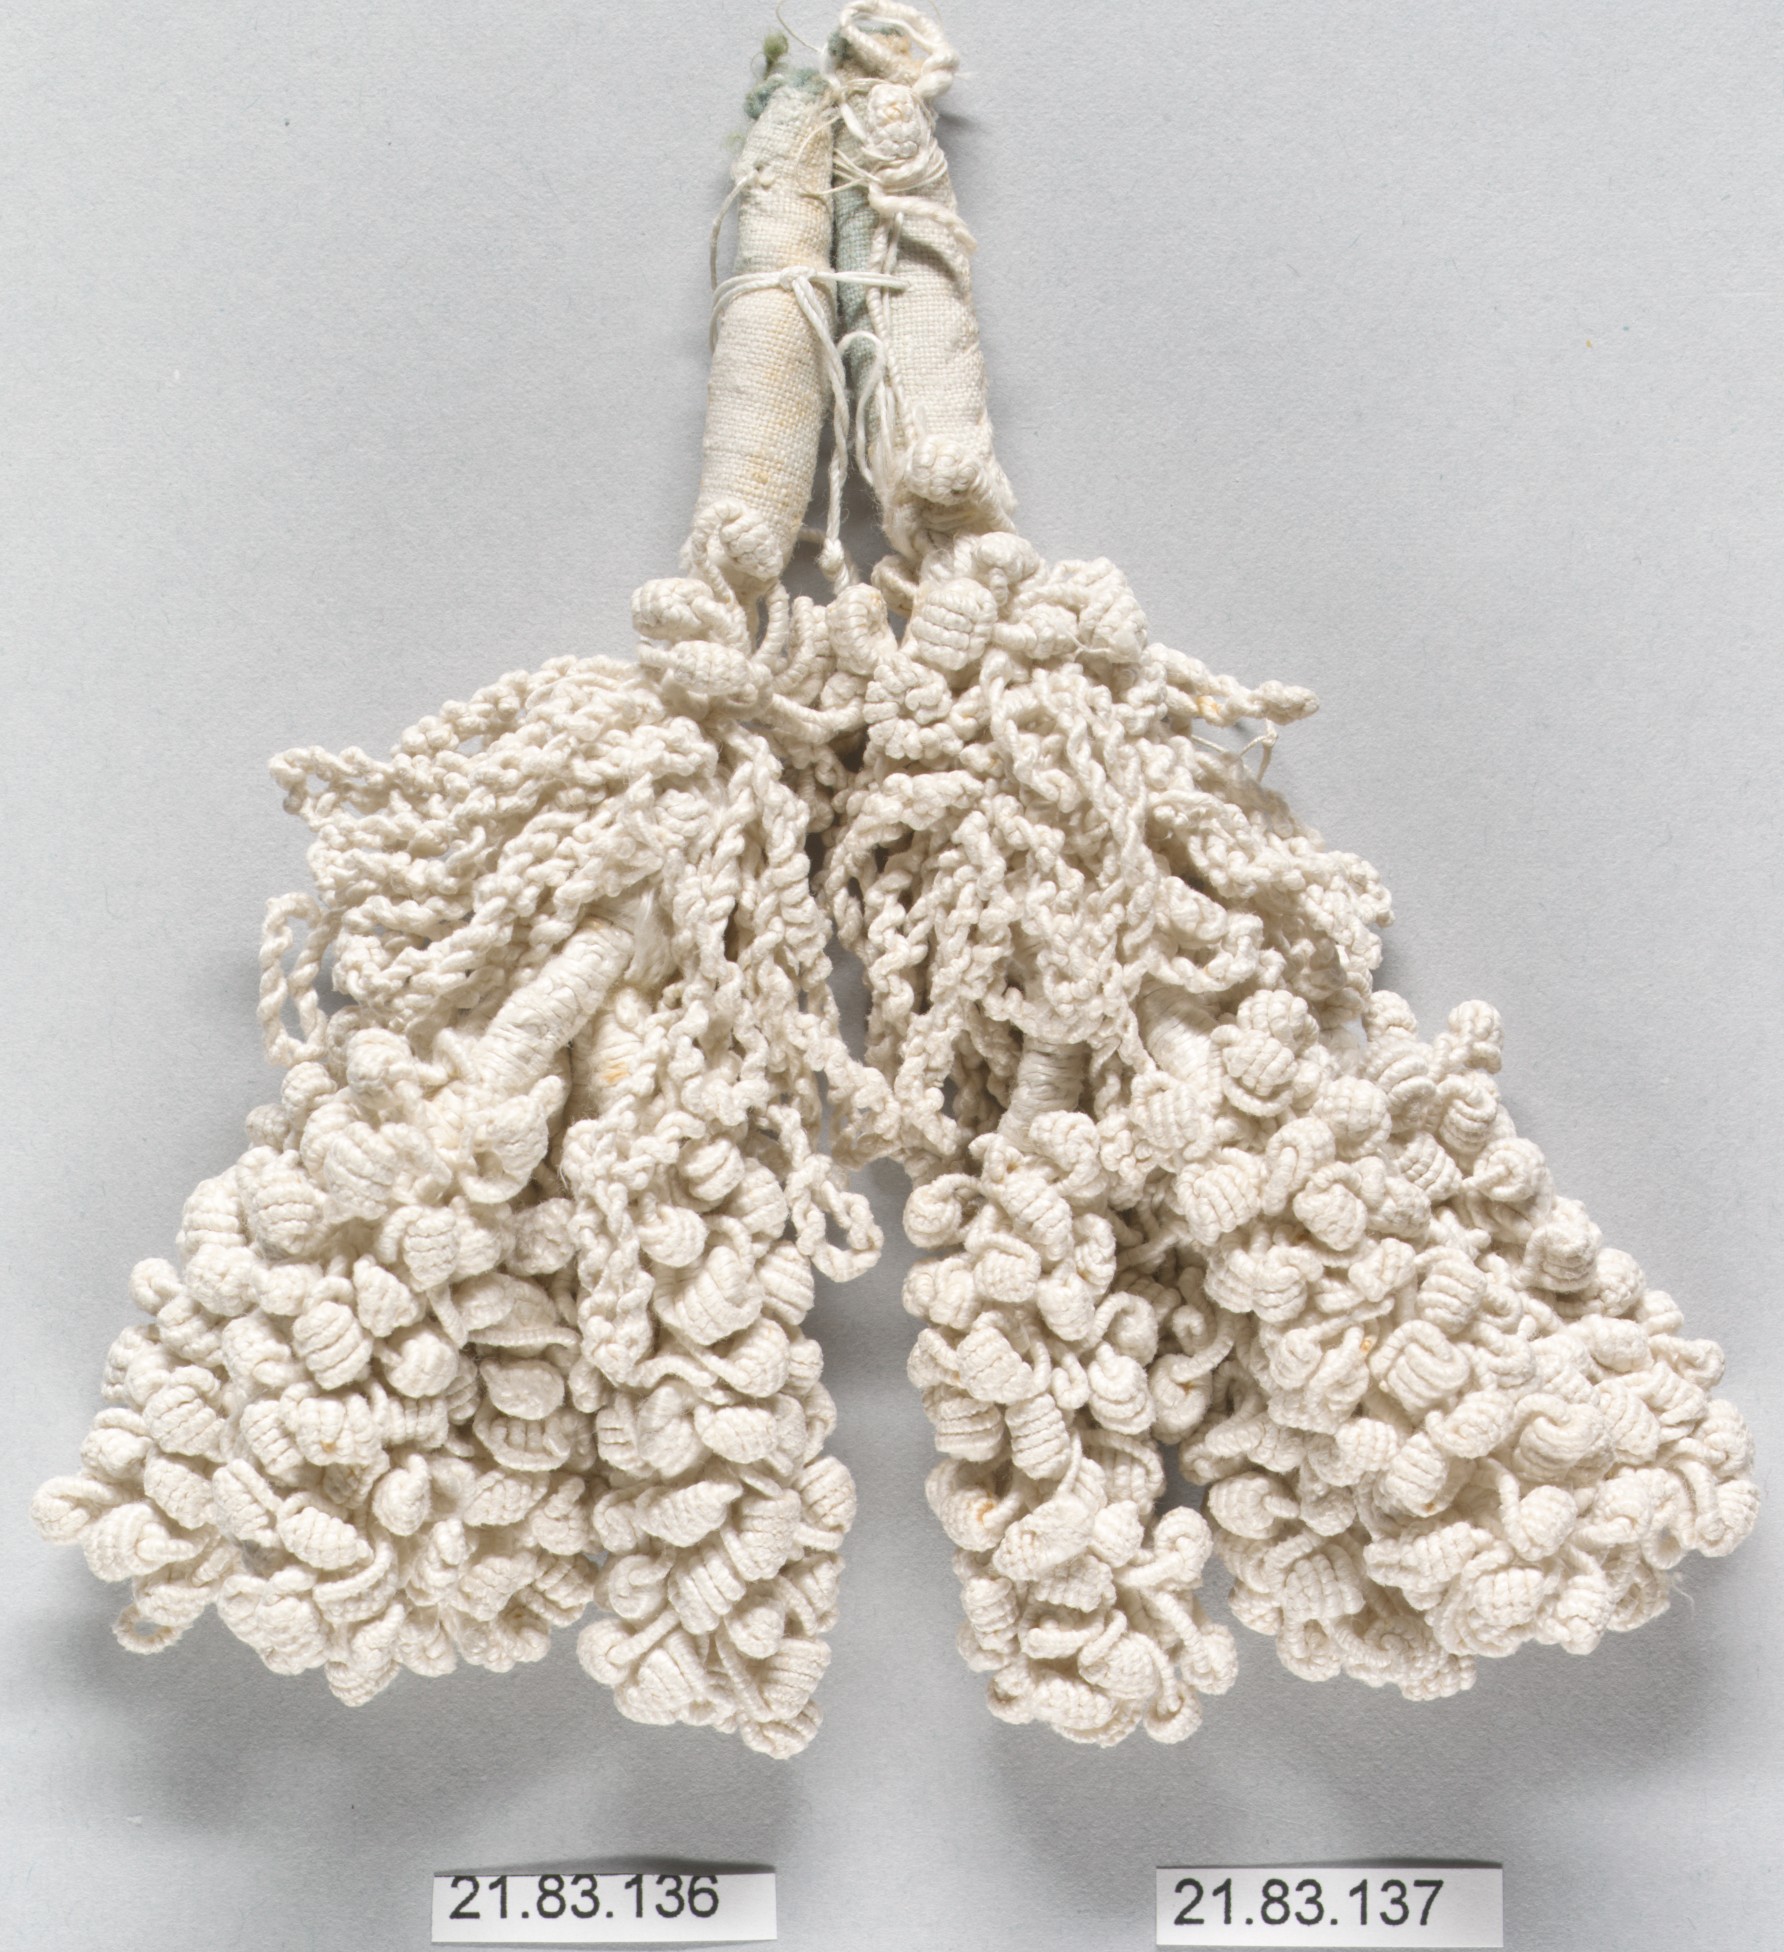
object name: tassel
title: Pair of tassels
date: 1601-1700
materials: linen